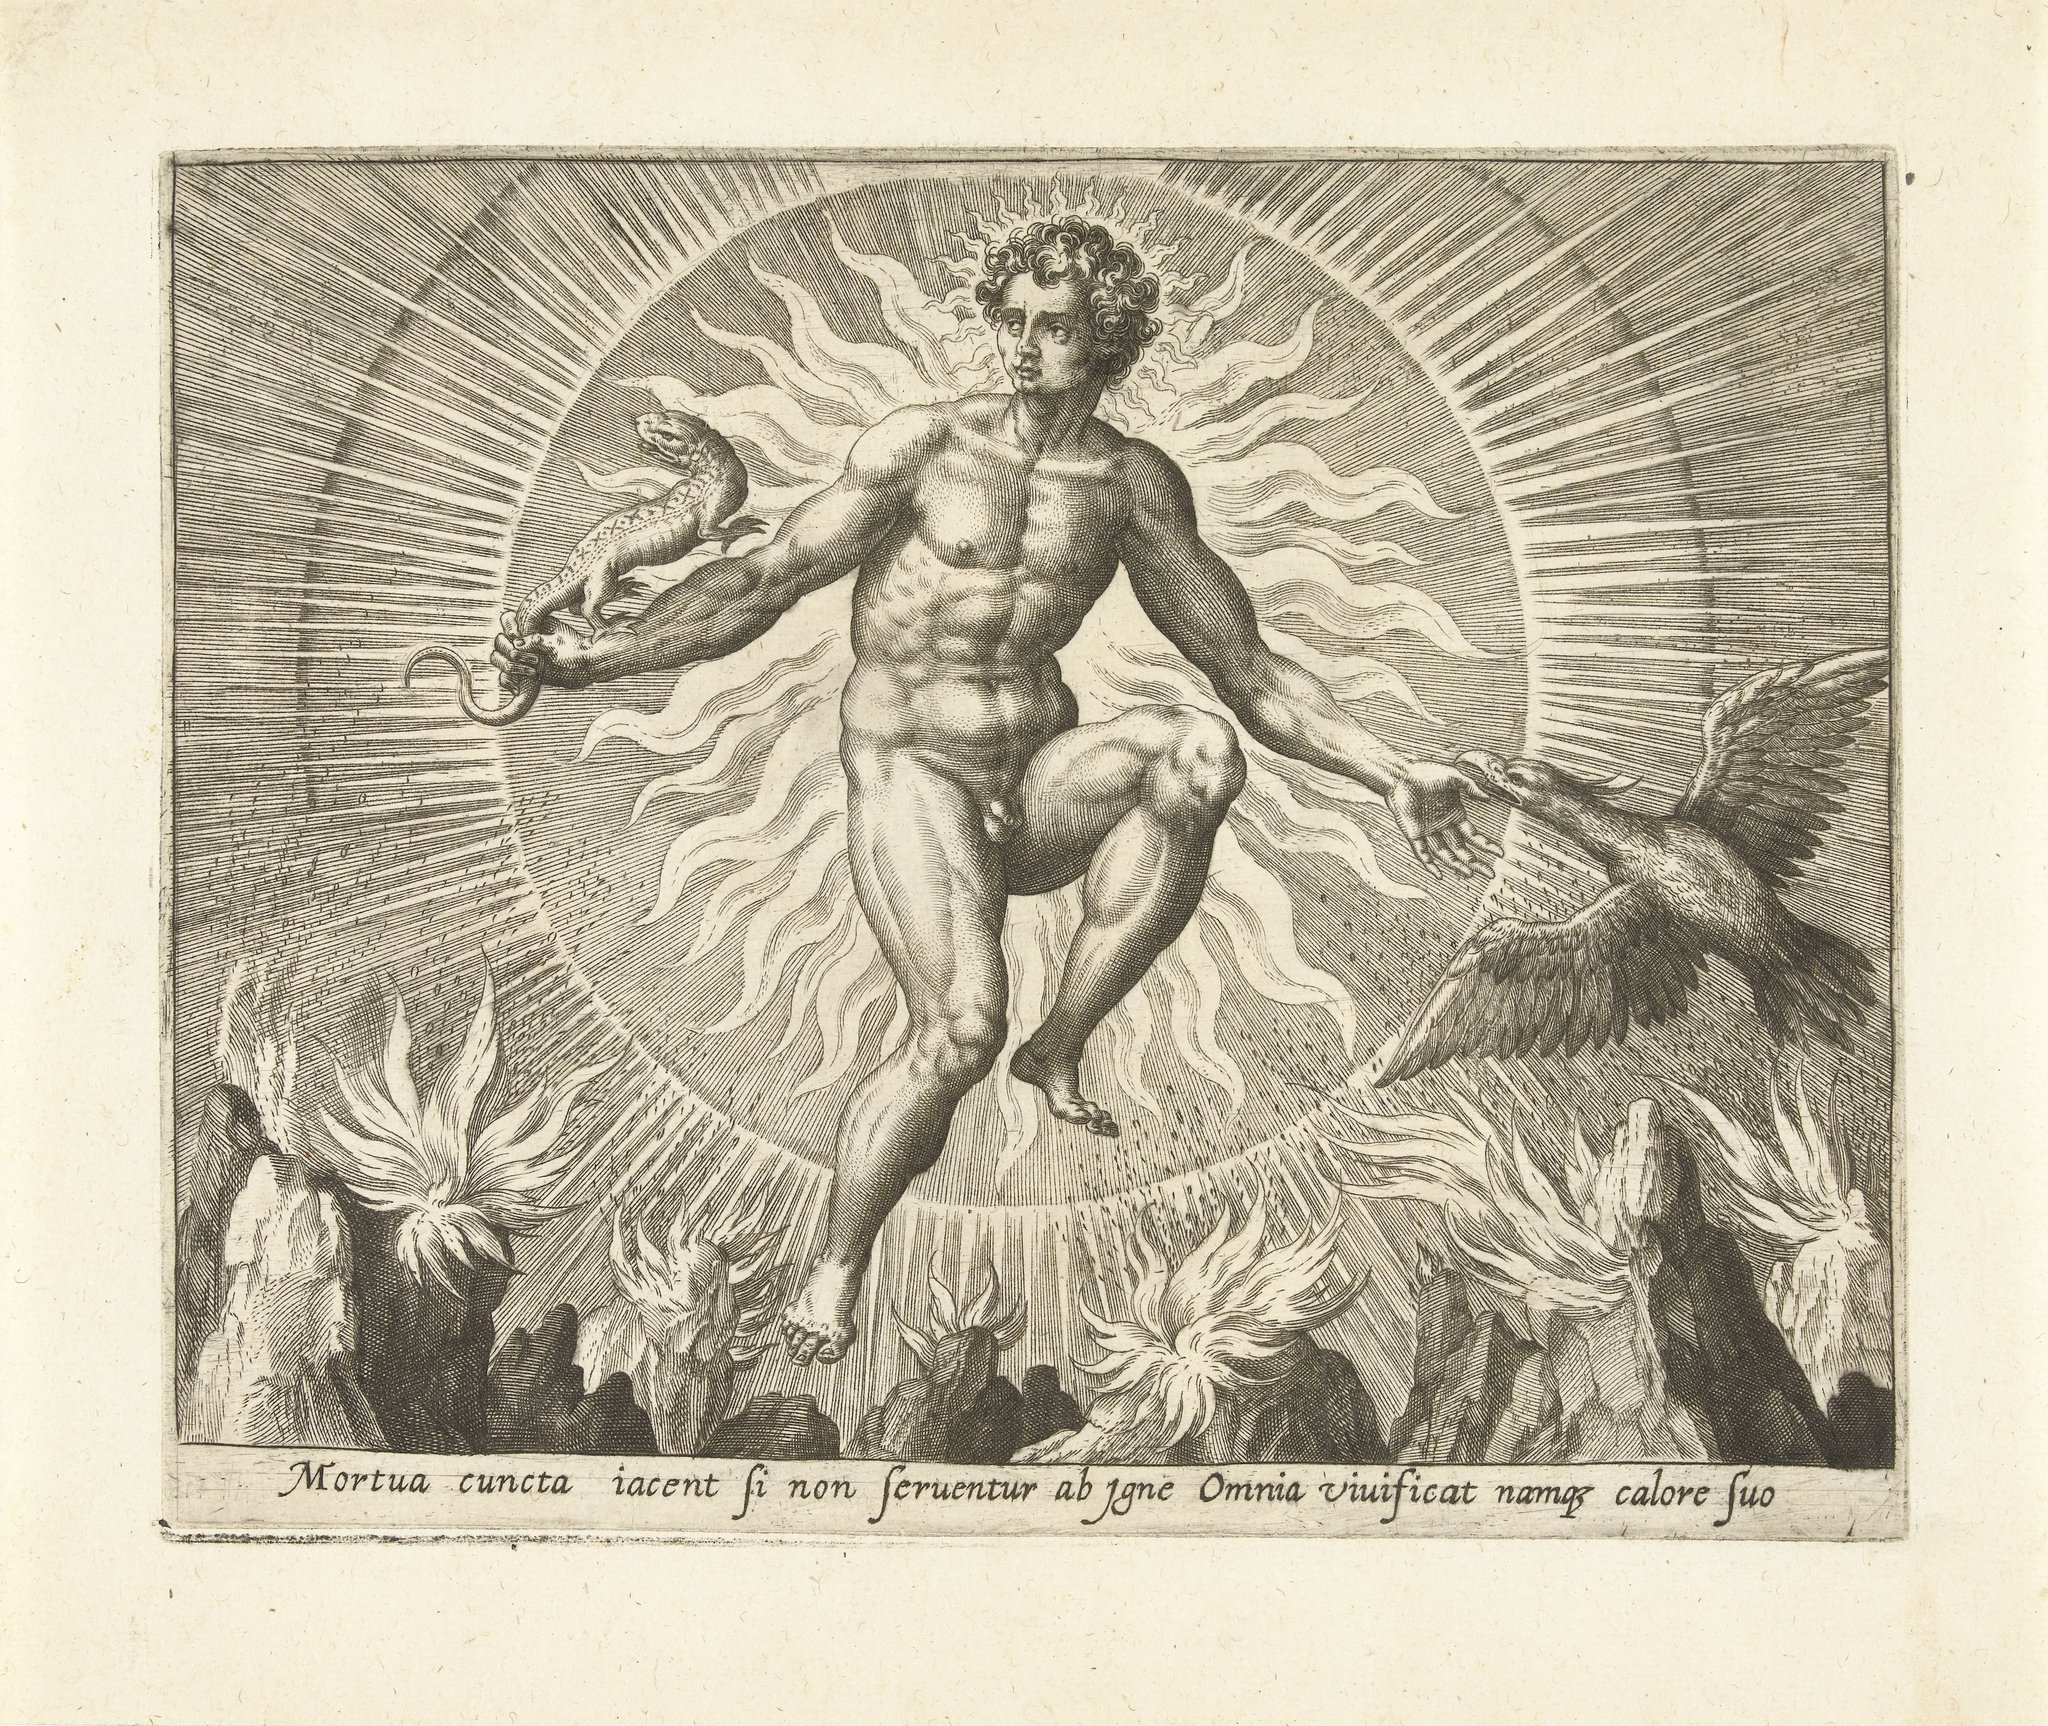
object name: print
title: De vier elementen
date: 1580-1584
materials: paper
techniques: engraving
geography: antwerp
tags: fire (one of the four elements)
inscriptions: collector's mark: Lugt 2228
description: Het element vuur, gepersonifieerd door de naakte zonnegod Helios. Hij is omringd door vlammen en houdt een salamander en in zijn ene hand en in zijn andere hand een feniks. De prent heeft een Latijns onderschrift. De prent is deel van een vierdelige serie over de vier elementen.